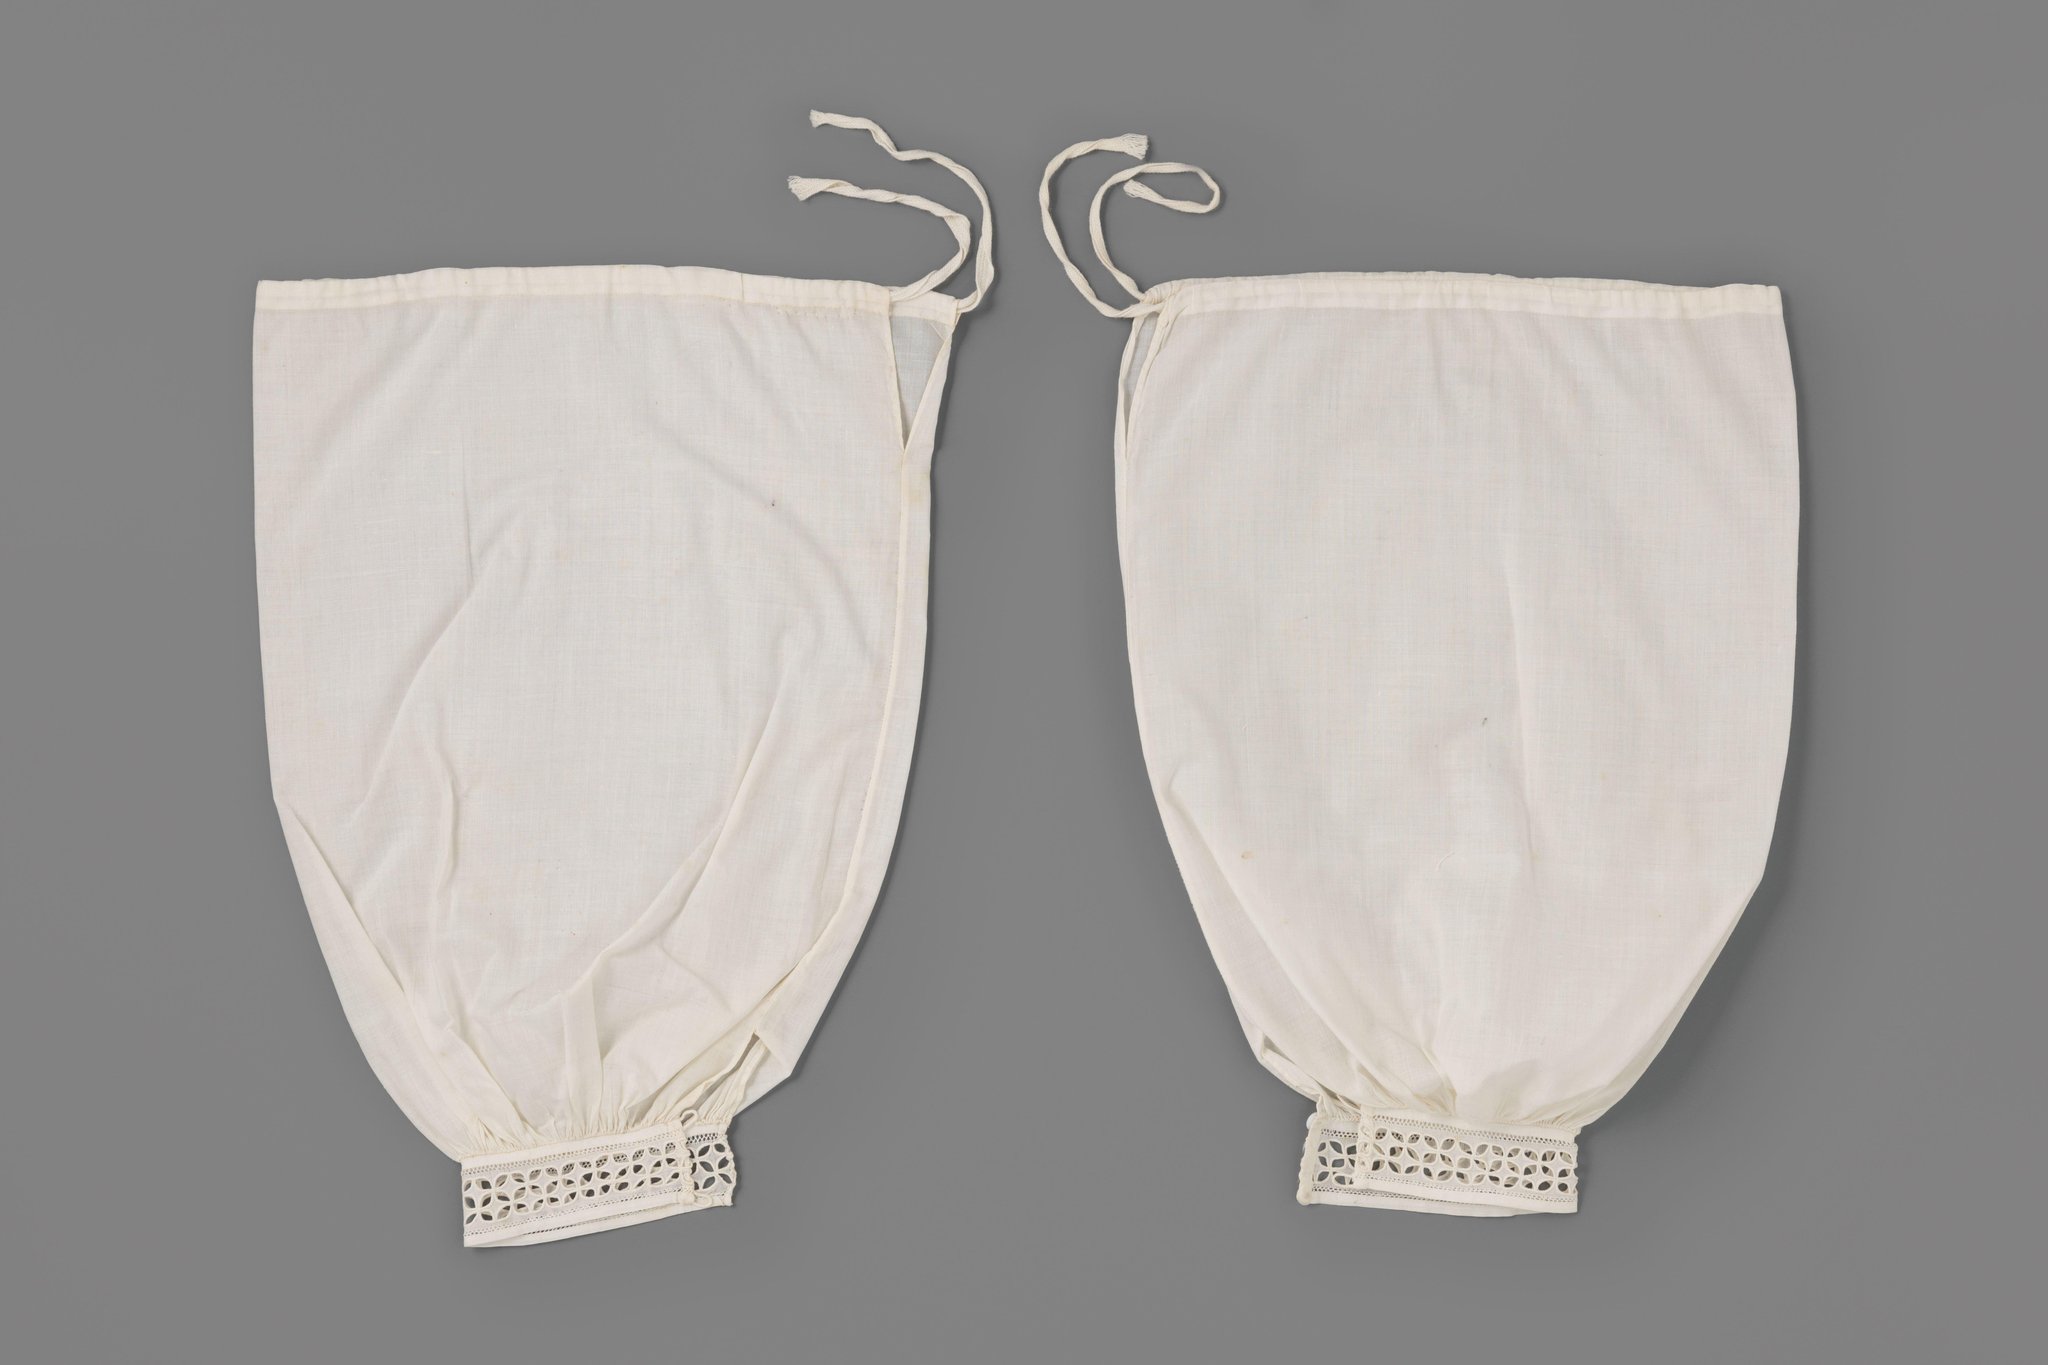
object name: undersleeve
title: Ondermouw van wit katoen, wijd model, met manchet waarop borduurwerk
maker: Anonymous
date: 1900-1910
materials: cotton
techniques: cockled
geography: western europe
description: Ondermouw van katoen, wijd model, voor een damesjapon. De ondermouw is gerimpeld bevestigd aan de manchet die is versierd met Engels borduurwerk. Aan de manchet één knoop. Aan de bovenzijde kan de ondermouw worden dichtgesnoerd door middel van een koord.